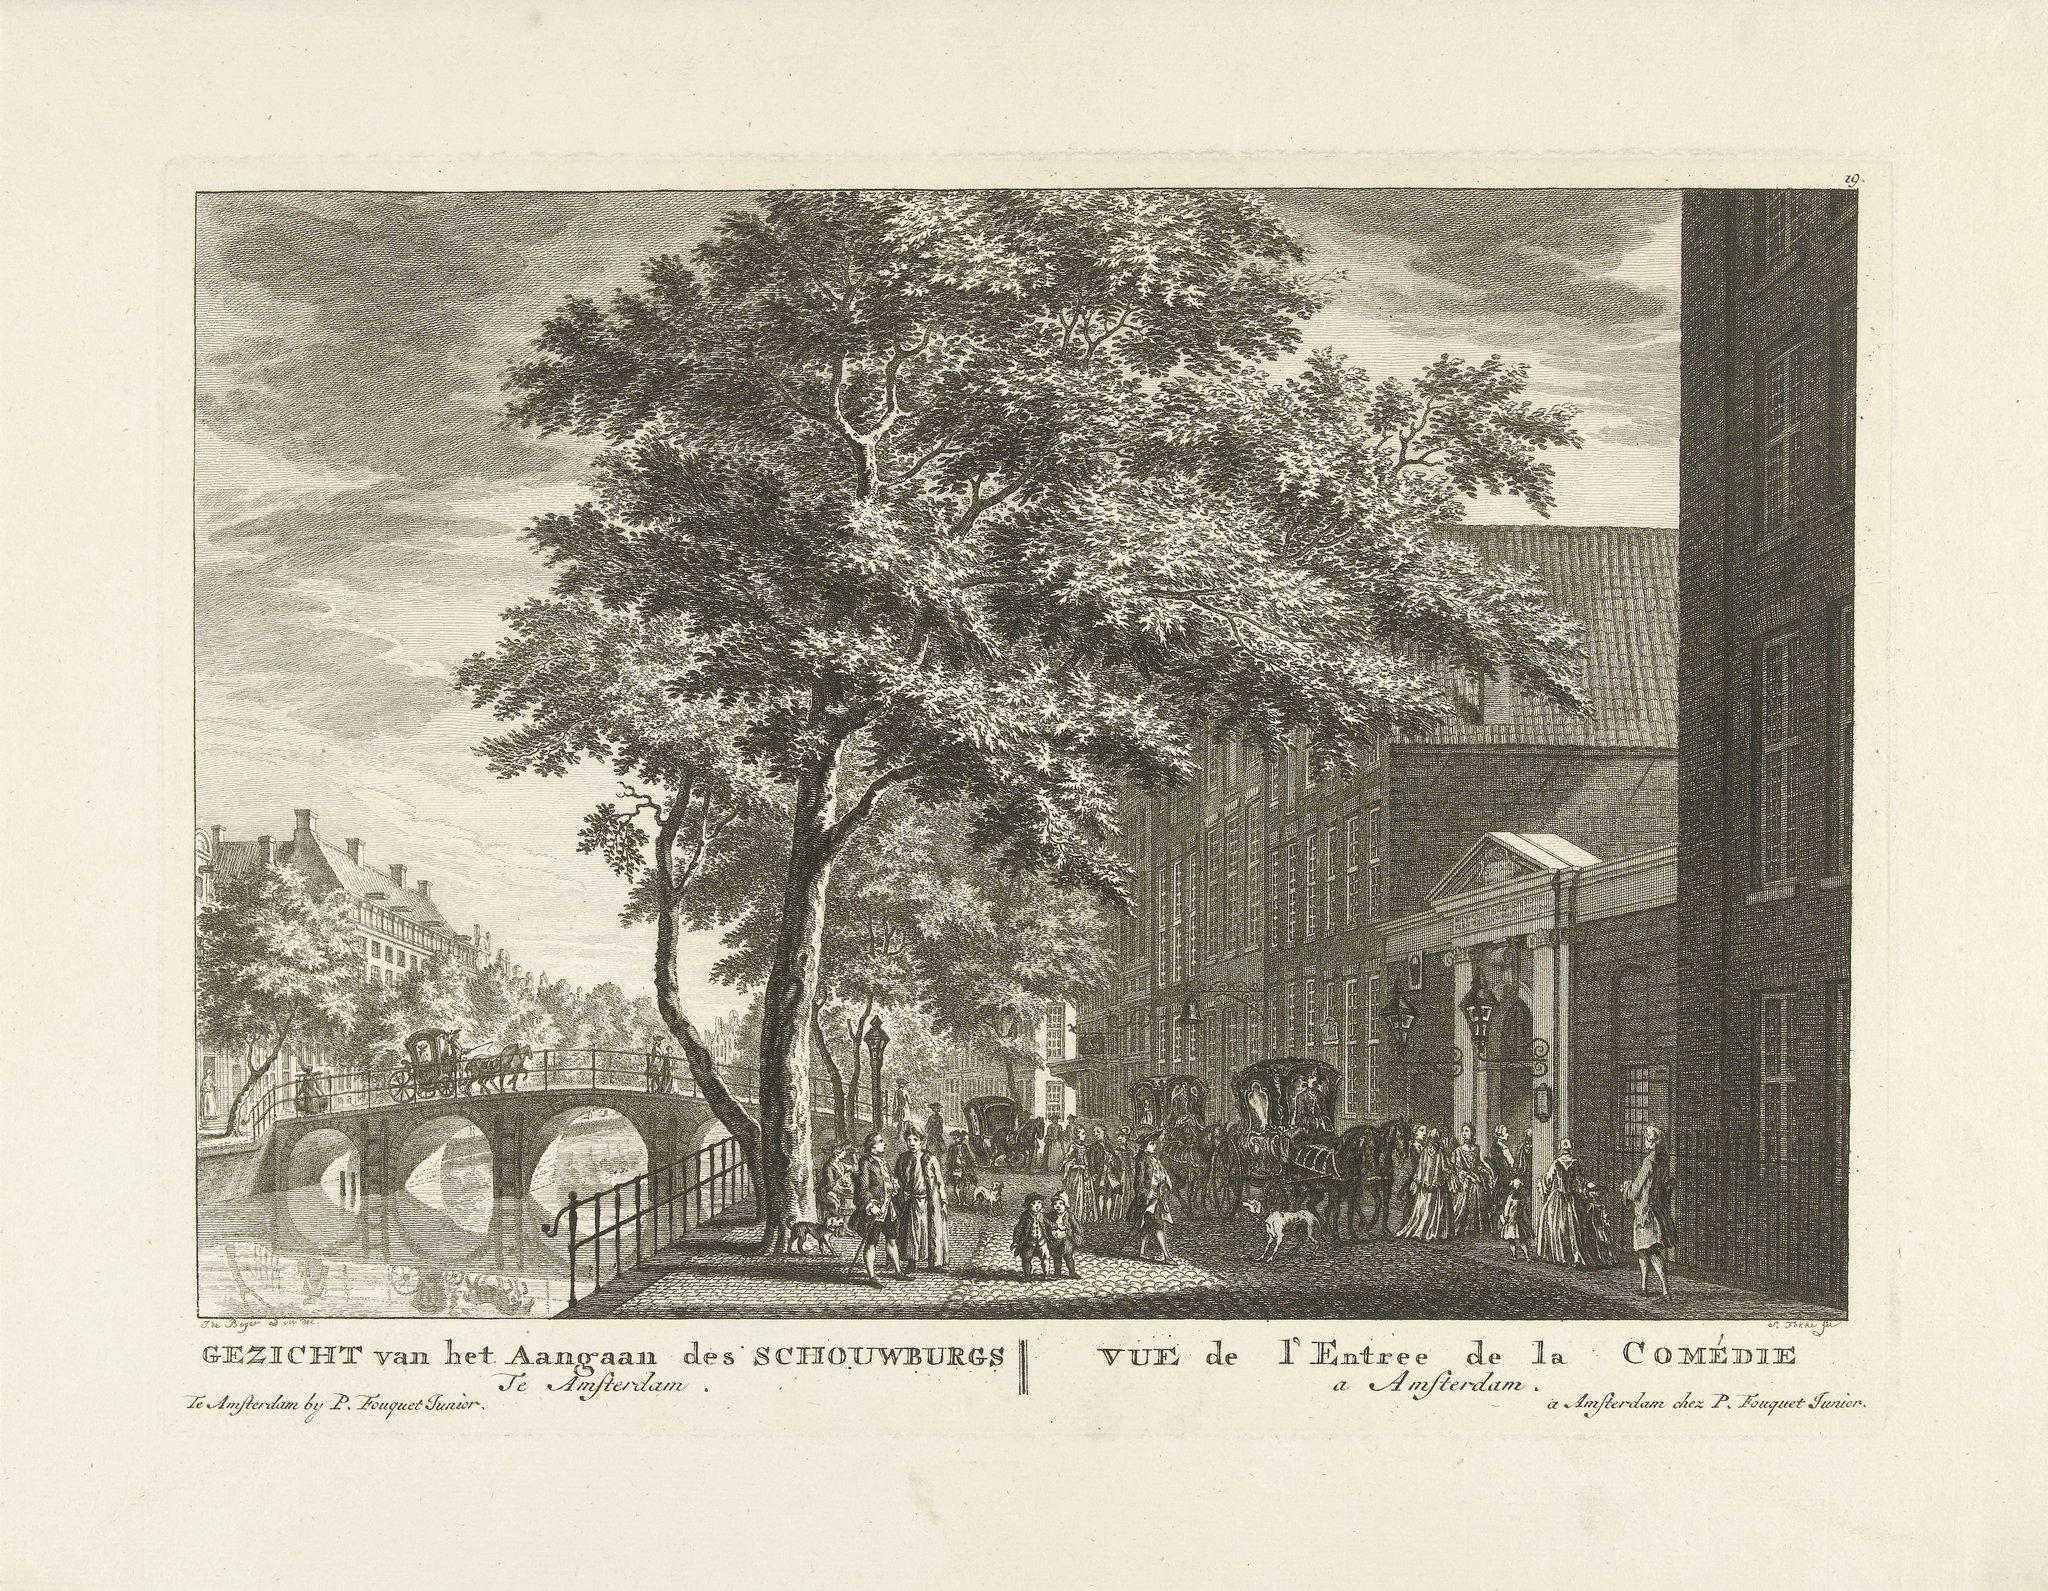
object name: print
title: Gezicht op de poort van de schouwburg aan de Keizersgracht te Amsterdam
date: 1760-1772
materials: paper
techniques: engraving, etching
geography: amsterdam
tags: theatre (building), gate, entrance, bridge in city across river, canal, etc., street (+ city(-scape) with figures, staffage)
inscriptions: collector's mark: Lugt 2228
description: Deze prent is ook gebruikt in de zogenaamde Atlas van Fouquet.* Pierre Fouquet gaf vanaf 1760 stadsgezichten van Amsterdam - naar tekeningen van verschillende kunstenaars, gemaakt door verschillende prentmakers - uit. Deze prenten werden aanvankelijk los of in series verkocht. Zoals toen gebruikelijk kon de koper de prenten zelf laten inbinden. Hiertoe gaf Fouquet tussen 1778 en 1783 een titelblad, plattegrond en inhoudsopgave van de tot dusver 100 uitgegeven prenten uit (1). Gezien de inhoud afhankelijk was van wat de koper had verzameld verschilt de inhoud van de verschillende bewaarde Fouquetatlassen onder deze titel sterk. Ook zijn er exemplaren bekend waar tevens andere prenten aan zijn toegevoegd. Omdat er behoefte bleek aan uitleg bij de platen werd in 1783 een nieuwe versie van de atlas uitgegeven, aangevuld met tekst en twee prenten. De aangegeven volgorde veranderde maar de platen van de al eerder uitgegeven prenten bleven ongewijzigd. Deze uitgave werd in opdracht van Fouquet gedrukt bij Daniël Jean Changuion en Petrus den Hengst (2). Een tiental platen werd bijgewerkt en verscheen, met nieuw impressum, in het vervolg van Wagenaars geschiedenis van Amsterdam, uitgeven door Petrus Conradi en Folkert van der Plaats (3). Een aantal jaar na het overlijden van Fouquet kwam Evert Maaskamp met een nieuwe uitgave van de atlas, met verbeterde tekst en toevoeging van twee prenten. Op alle platen verwijderde hij het oude en liet hij zijn eigen impressum zetten (4). De huidige staat van de prent komt voor in exemplaren van de onder (1) en (2) genoemde werken. * Onder de Atlas van Fouquet of Fouquetatlas verstaan we de hieronder vermelde publicaties (1), (2) en (4). (1). Afbeeldingen van de wyd-vermaarde koopstad Amsterdam benevens des zelvs voornaamste gebouwen en gezigten alle naar het leeven getekend / Receuil des edifices les plus considerables et des plus belles vues, de la fameuse ville d'Amsterdam, dessinées d'après nature. Amsterdam: Pierre Fouquet, 1778-1783. (2). Nieuwe atlas, van de voornaamste gebouwen en gezigten der stad Amsterdam, met derzelver beknopte beschryvingen. 2 delen. Amsterdam: Daniël Jean Changuion en Petrus den Hengst [in opdracht van Pierre Fouquet], 1783. (3). Stijl, Simon. Amsterdam, in zyne geschiedenissen, voorregten, koophandel, gebouwen, kerkenstaat, schoolen, schutterye, gilden en regeeringe, beschreeven. Om te dienen ten vervolge op het werk van Jan Wagenaar (…). 10 delen. Amsterdam en Harlingen: Petrus Conradi en Folkert van der Plaats, 1788-1801. (4). Nieuwe atlas, van de voornaamste gebouwen en gezigten der stad Amsterdam. Met derzelver beknopte beschryvingen. Amsterdam: Evert Maaskamp, 1805. * Het aantal vermelde staten is gebaseerd op het aantal gevonden staten. Mogelijk zijn er meer staten van deze prent. Voor derde bekende staat zie RP-P-AO-25-84.